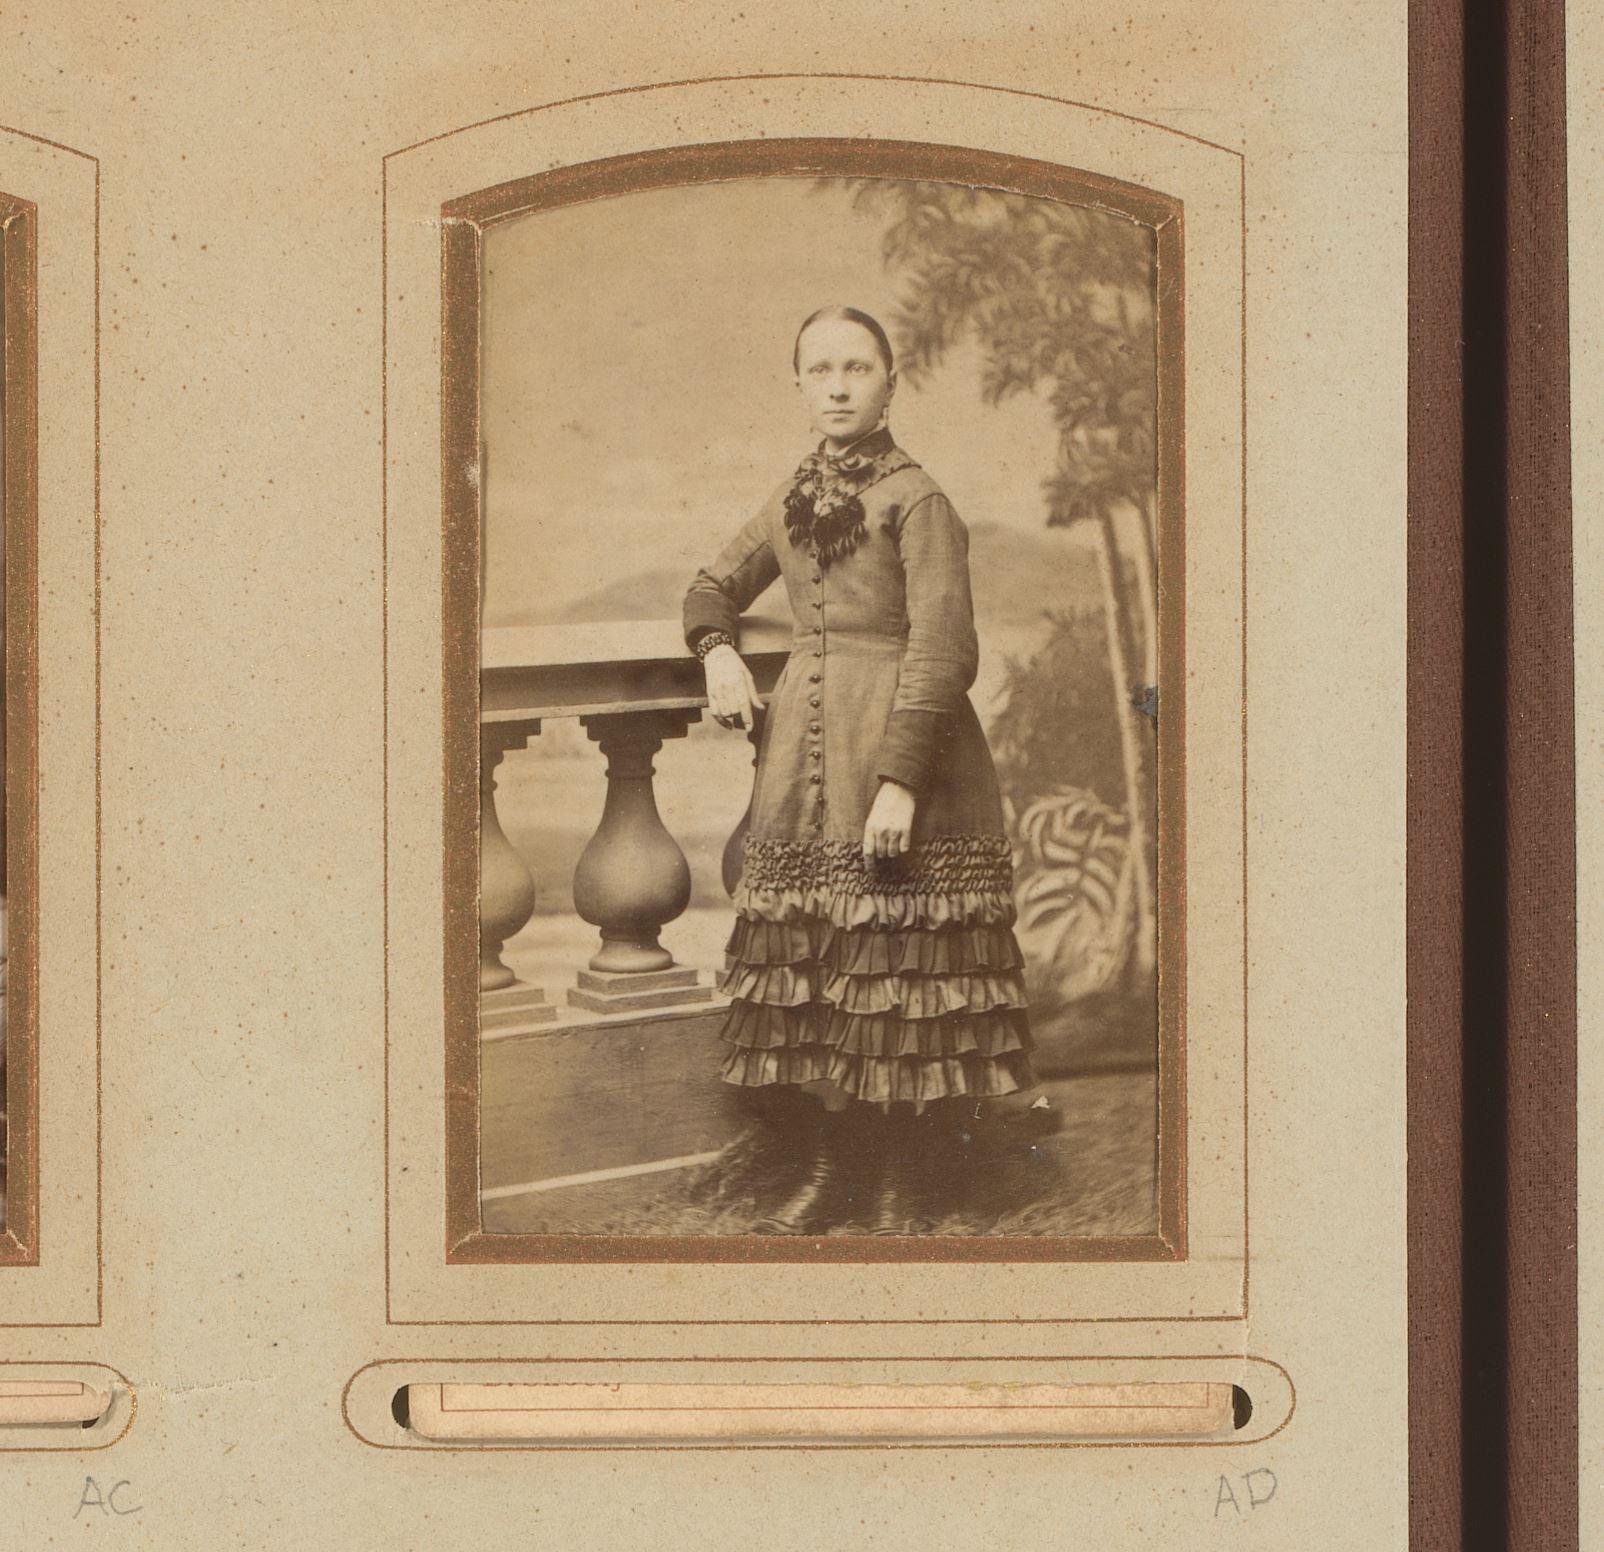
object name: photograph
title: Portret van een meisje, staand bij een balustrade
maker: david snooij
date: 1878-1889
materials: cardboard, photographic support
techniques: albumen print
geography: amsterdam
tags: historical persons - bb - woman, girl (child between toddler and youth), balustrade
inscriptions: inscription: ‘Photographisch/ Atelier/ D. Snooij/ Amsterdam/ Rozengracht No. 11.’